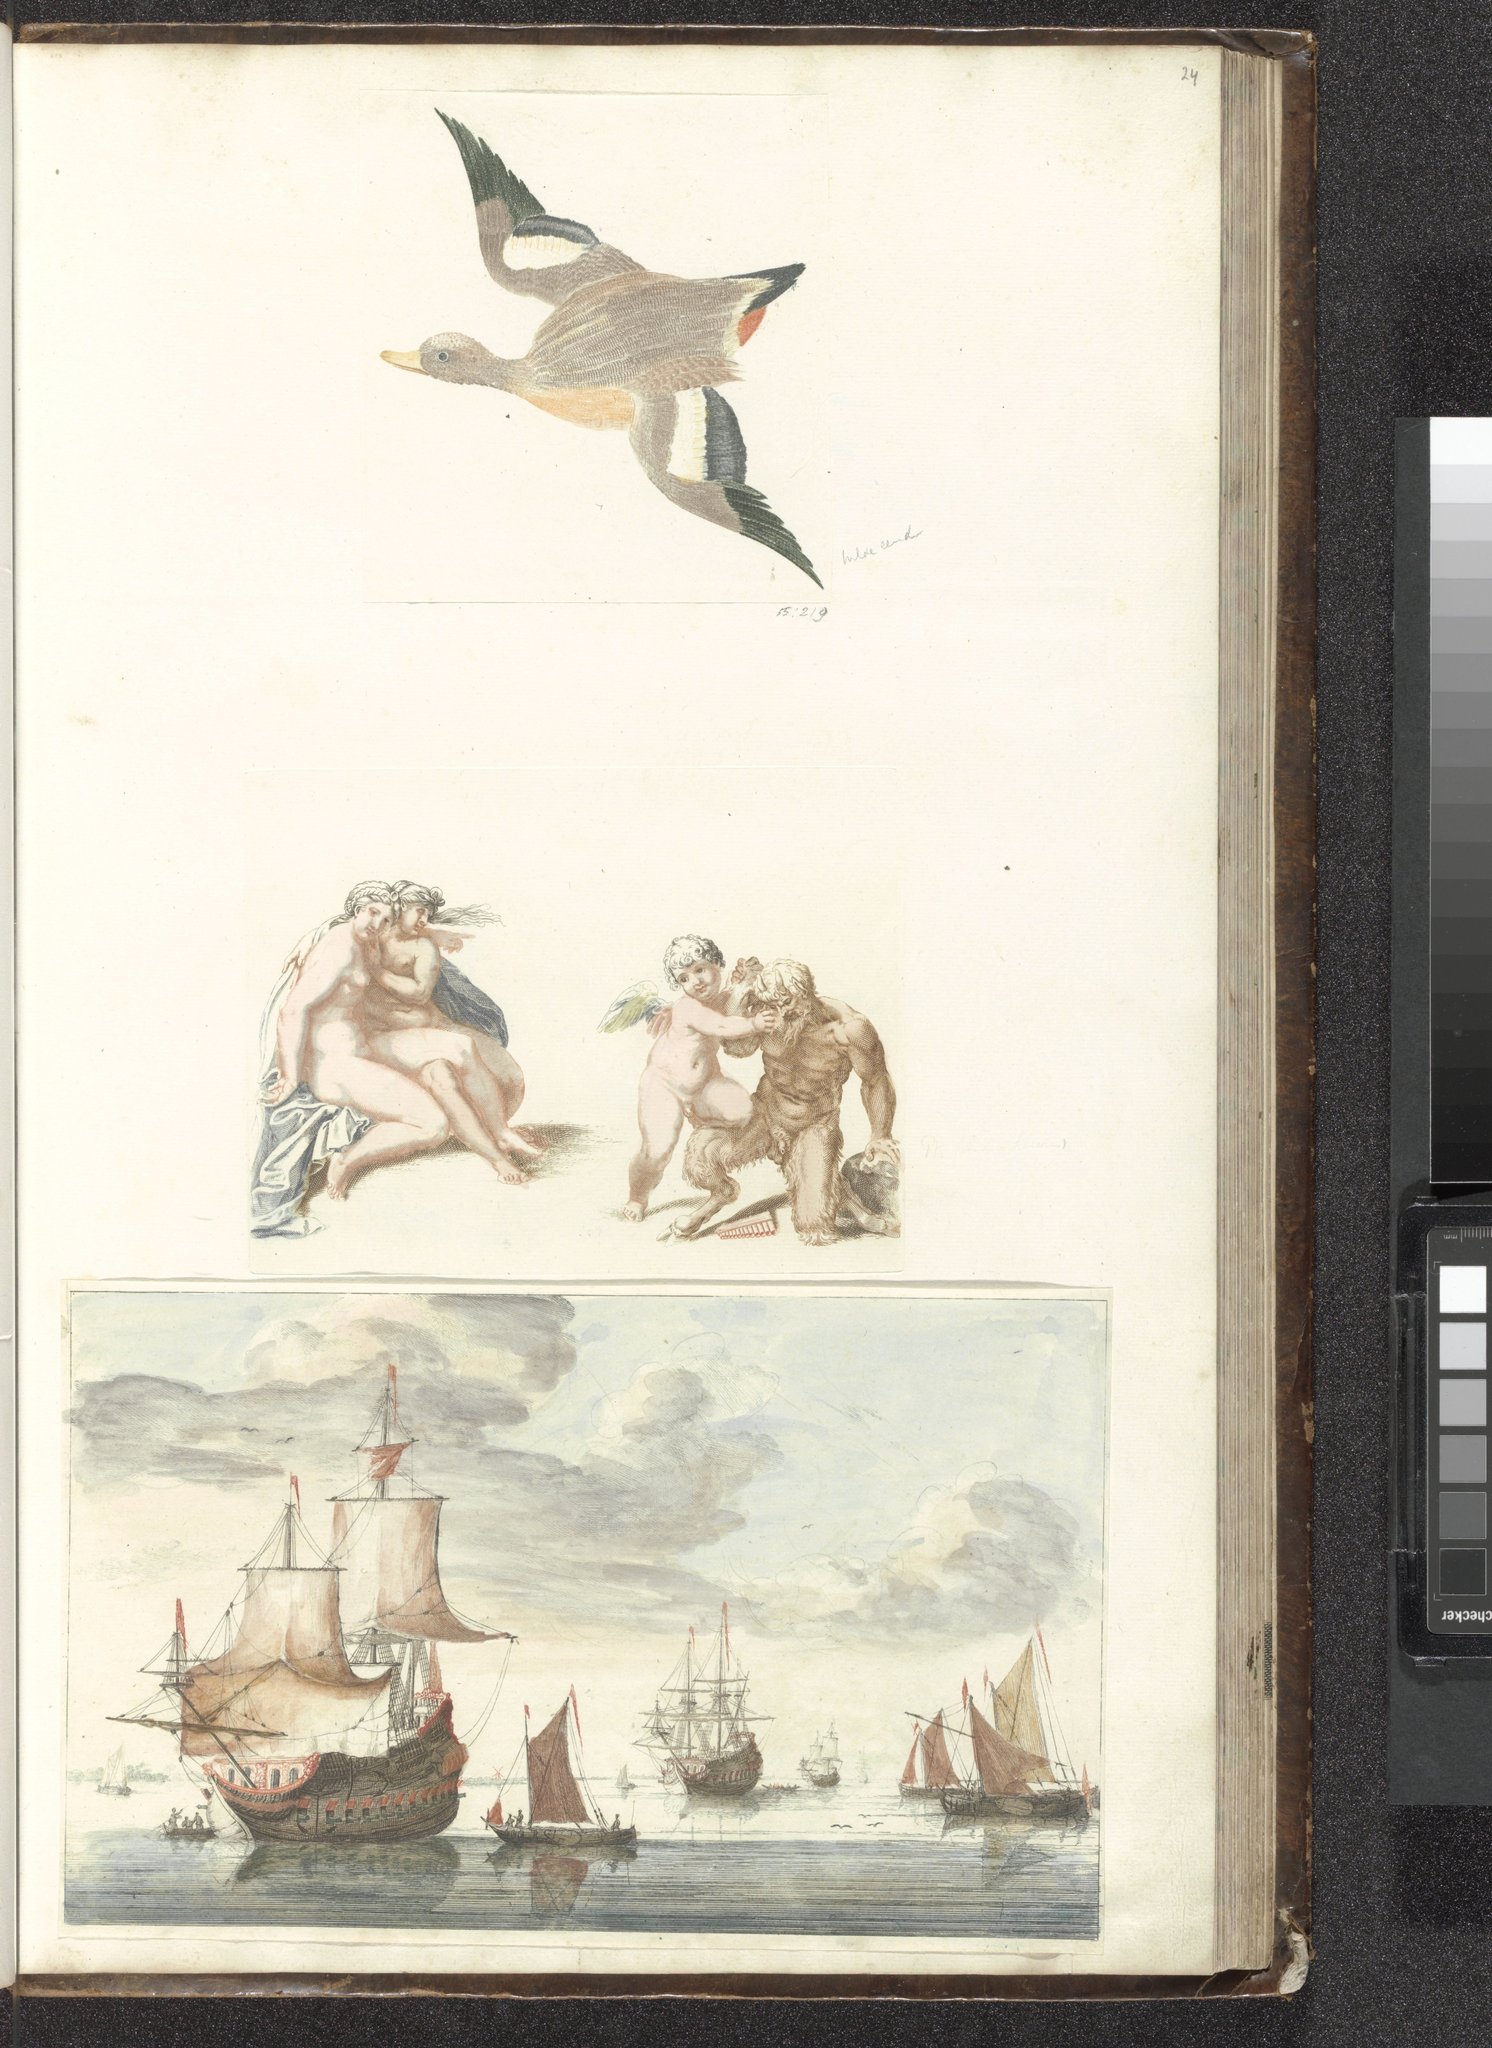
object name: album leaf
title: Naar links vliegende eend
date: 1688-1698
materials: paper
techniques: printing, printmaking, engraving, lithography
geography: netherlands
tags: water-birds: duck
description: Deze prent maakt deel uit van een album.